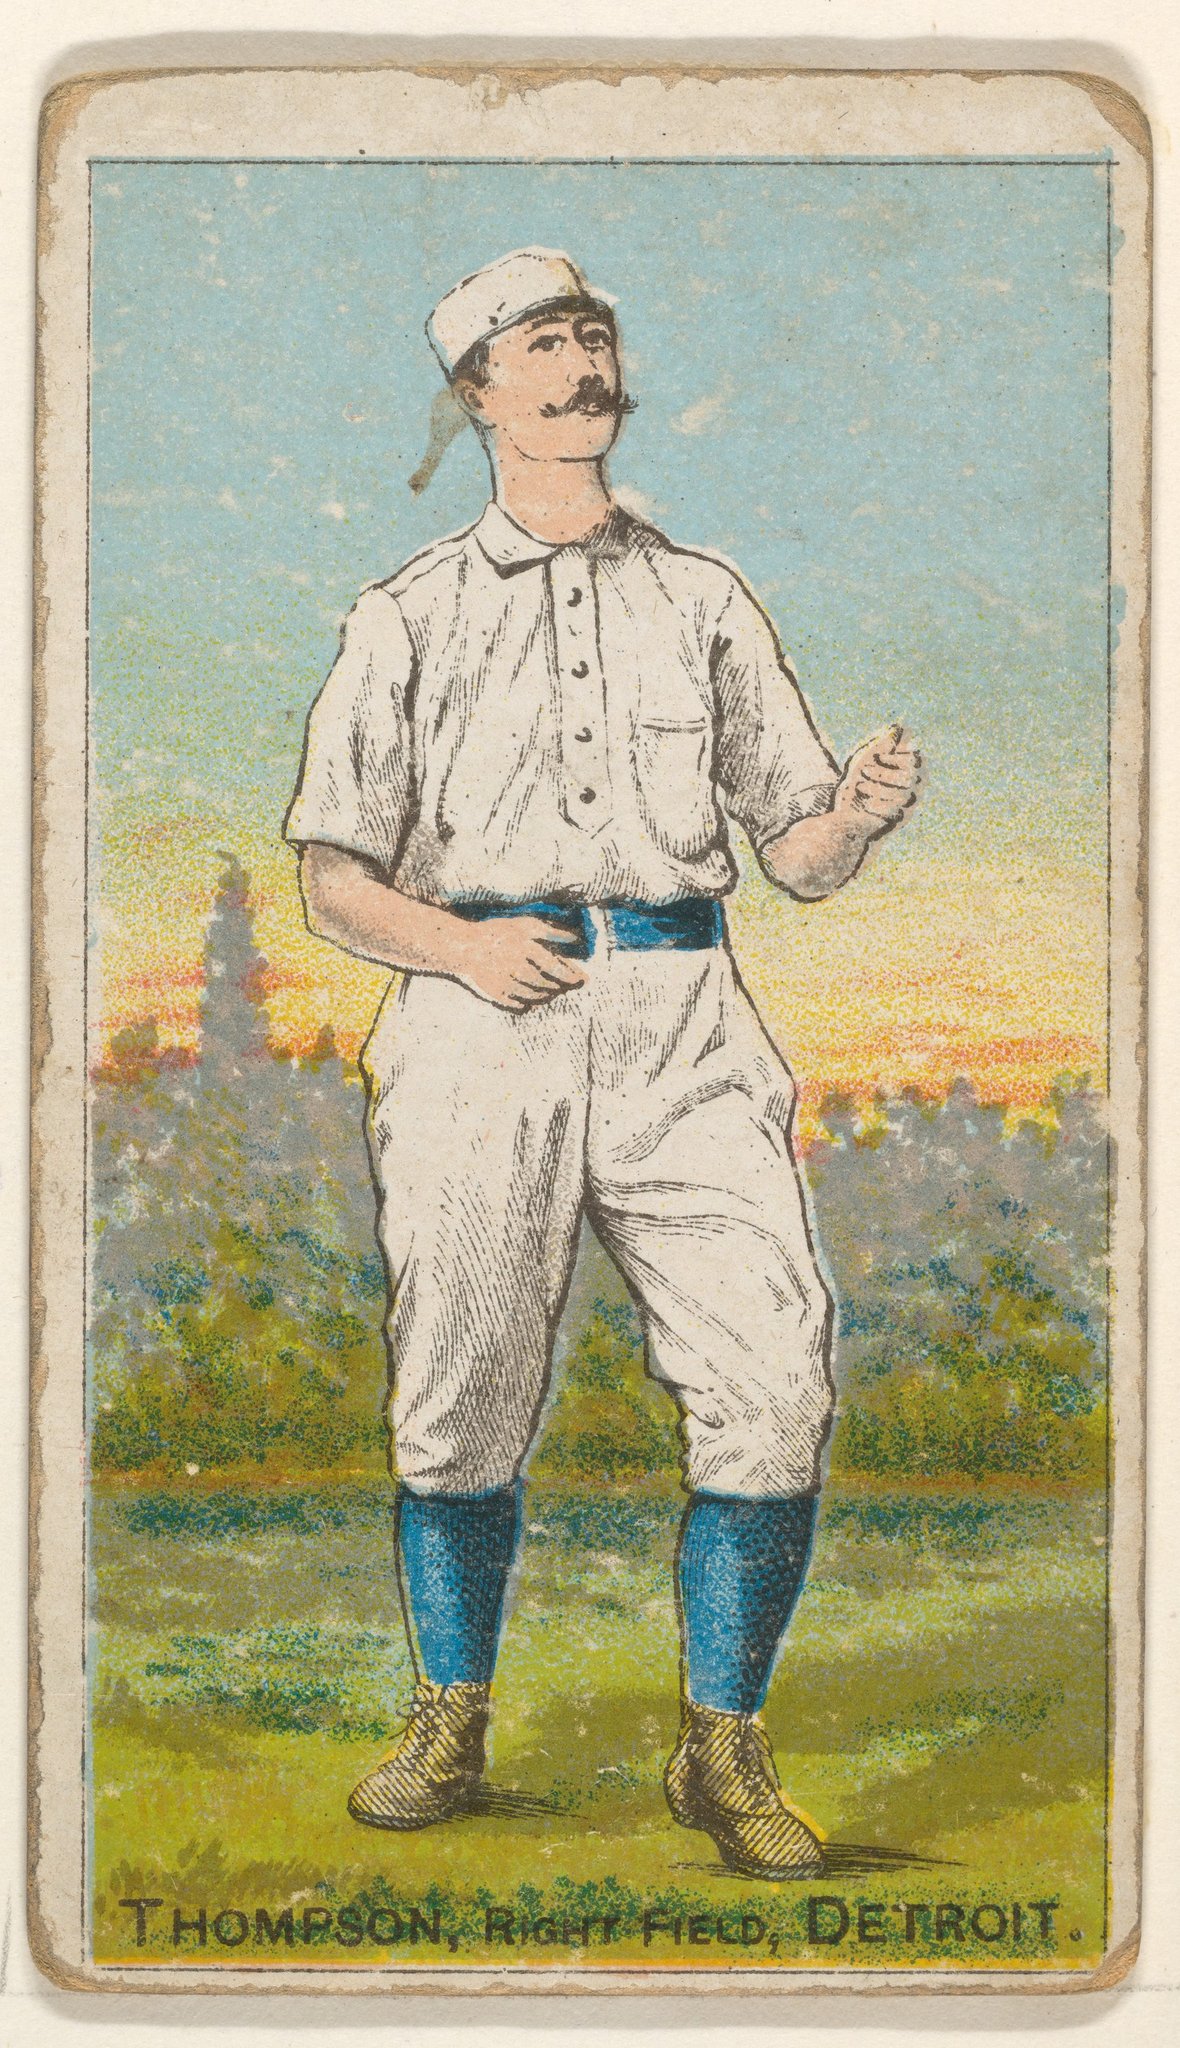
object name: baseball card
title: Thompson, Right Field, Detroit, from the Gold Coin series (N284) for Gold Coin Chewing Tobacco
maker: d. buchner & co., new york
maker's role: publisher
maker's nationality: american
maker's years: 1850-1900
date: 1887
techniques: color lithograph, drawing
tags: men,baseball,athletes